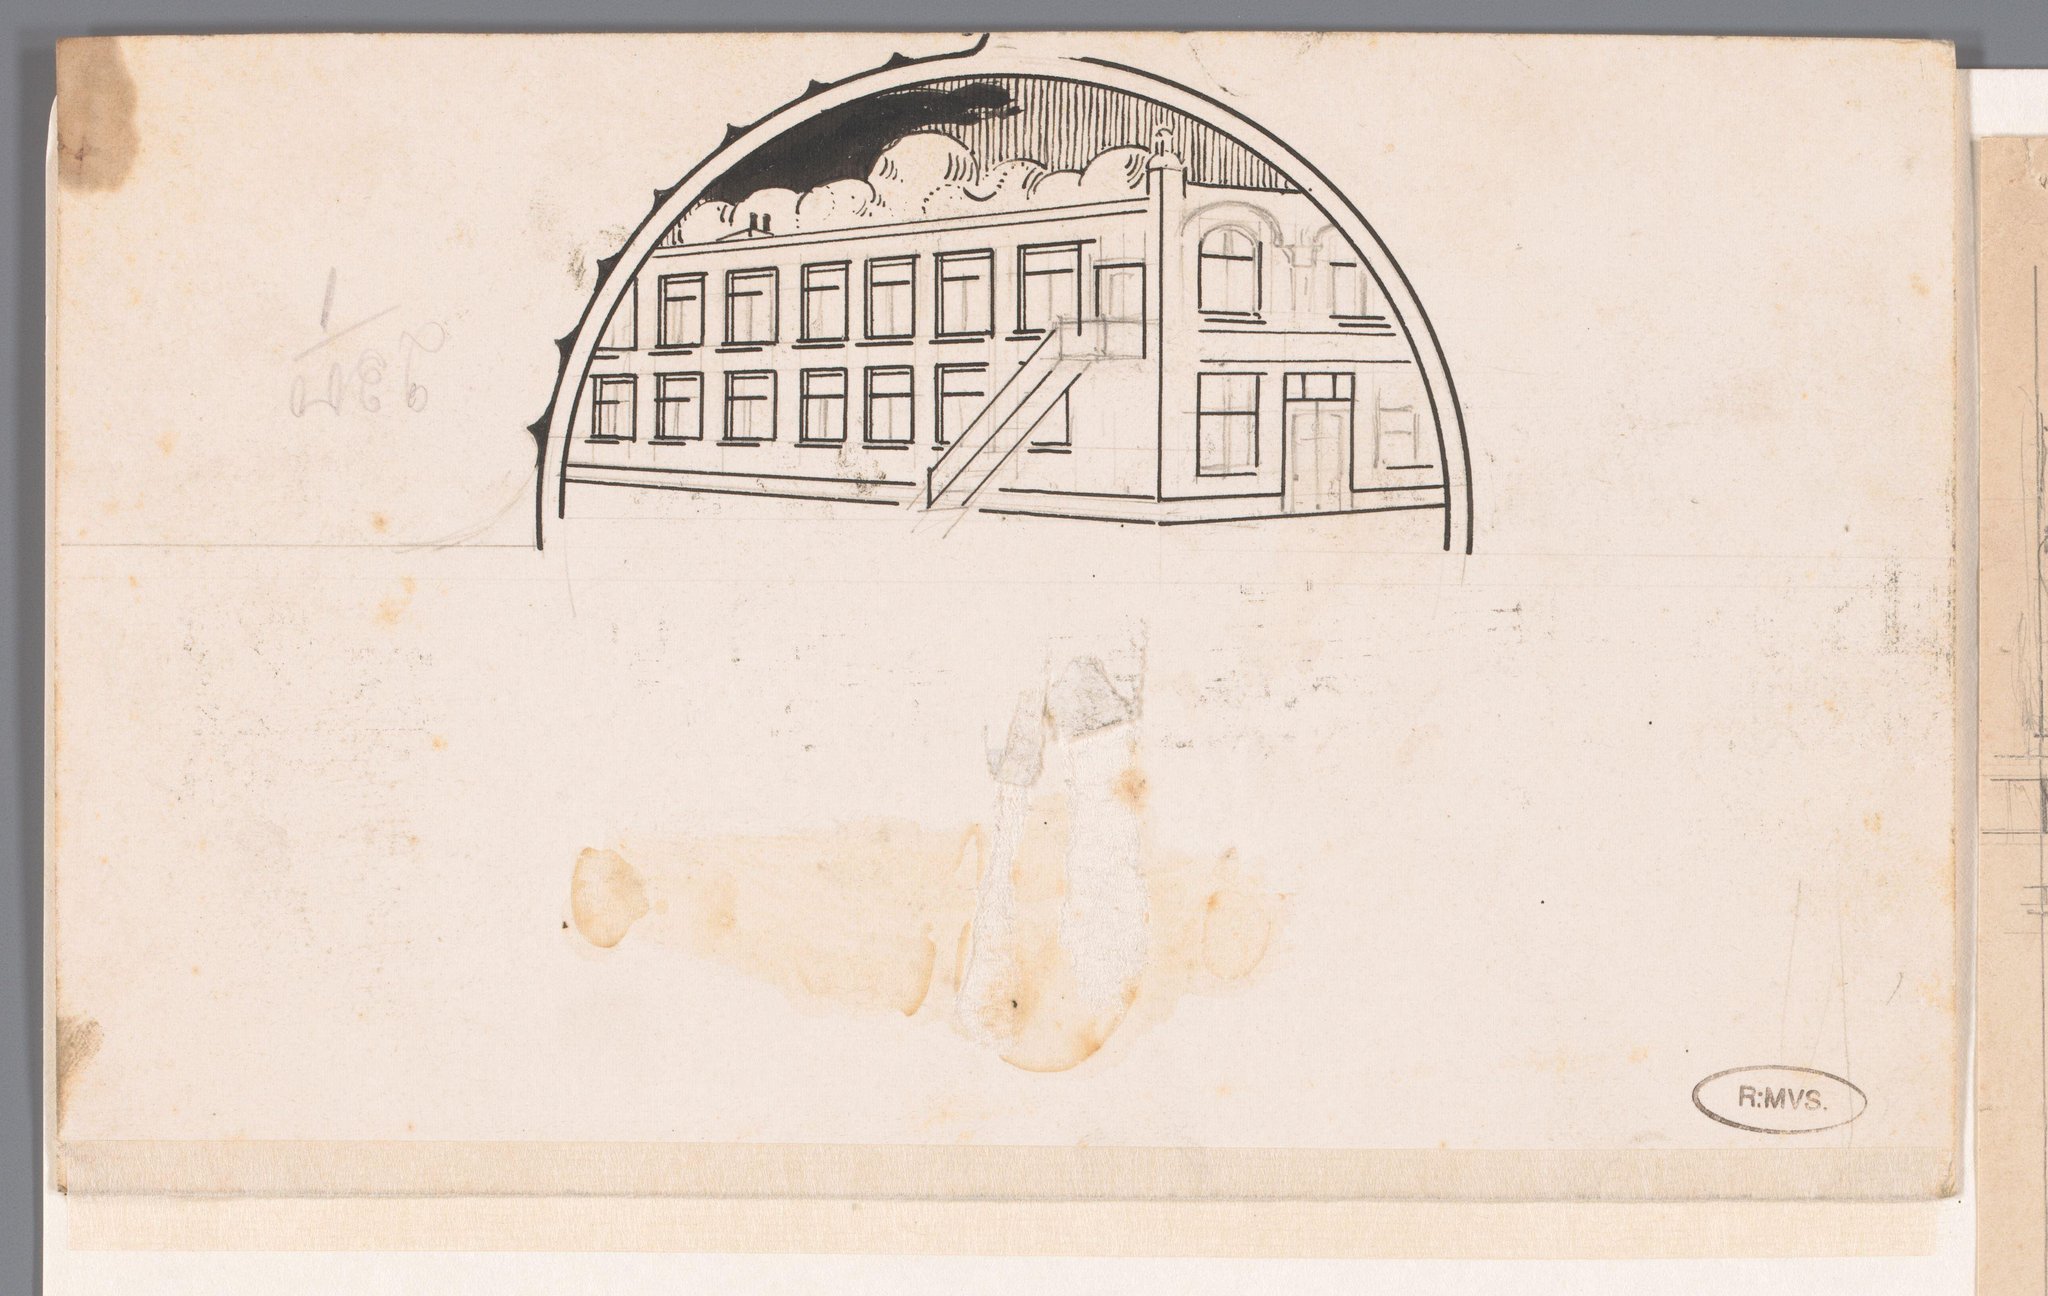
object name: drawing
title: Ontwerp voor een briefhoofd van Motshagens handel in apotheek- en drogisterijbenodigdheden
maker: reinier willem petrus de vries (1874-1953)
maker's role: draughtsman, print maker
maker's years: 1874-1953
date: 1884-1952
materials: ink, paper, pencil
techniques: brush, pen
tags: large-scale structure for storage, e.g.: warehouse, depot, silo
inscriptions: collector's mark: ‘R:MVS.’, annotation: ‘2300/1’